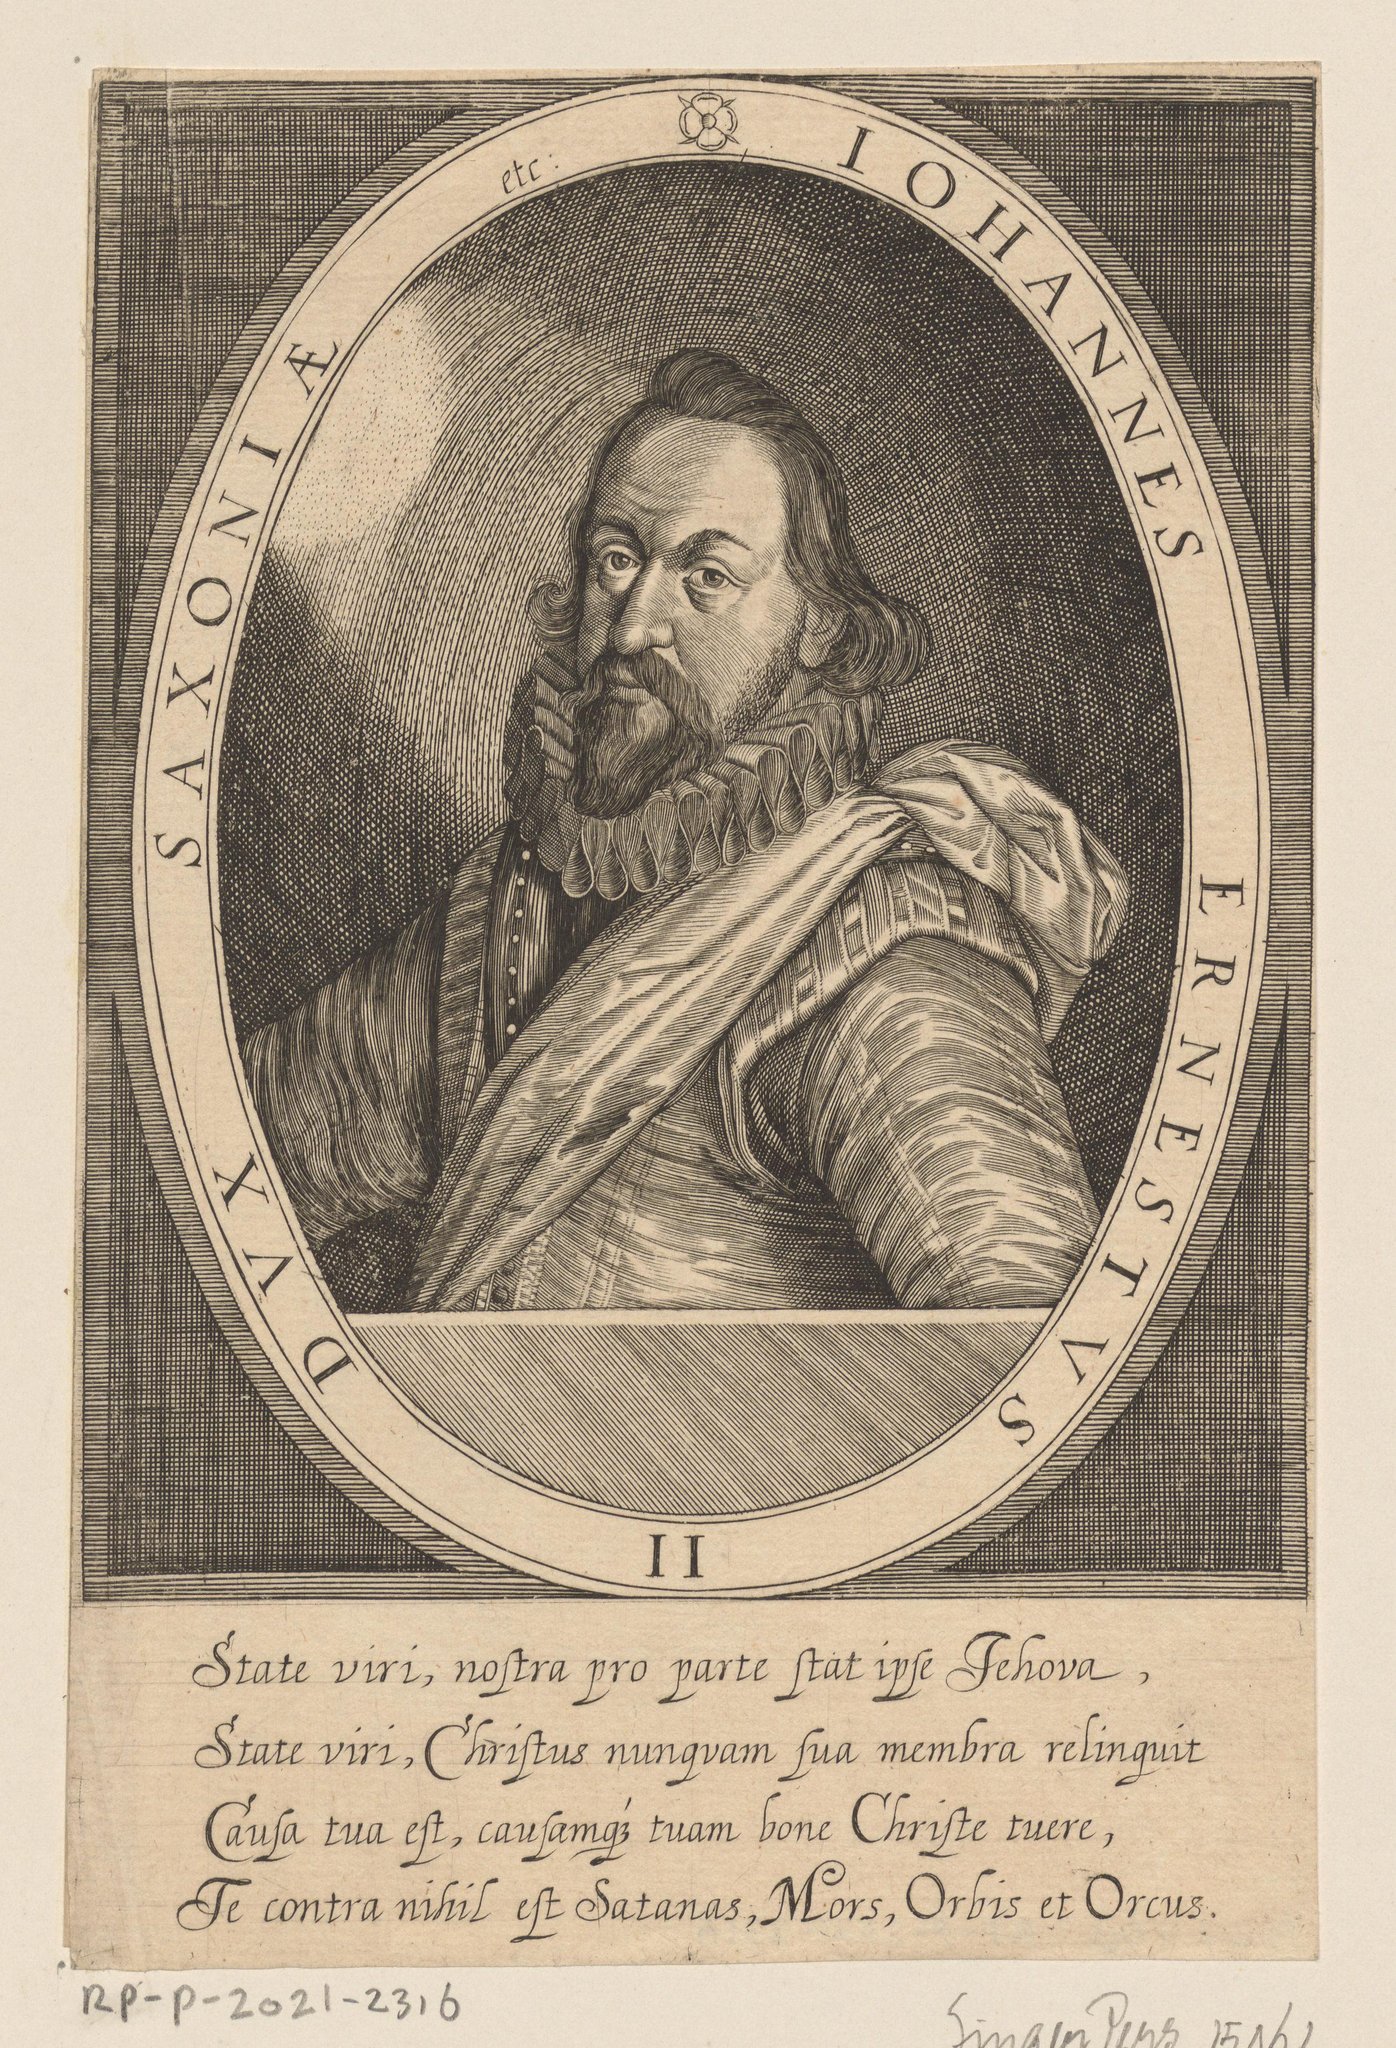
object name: print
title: Portret van Johann Ernst II, hertog van Saksen-Weimar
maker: Anonymous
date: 1600-1699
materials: paper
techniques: engraving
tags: historical persons, ruler, sovereign